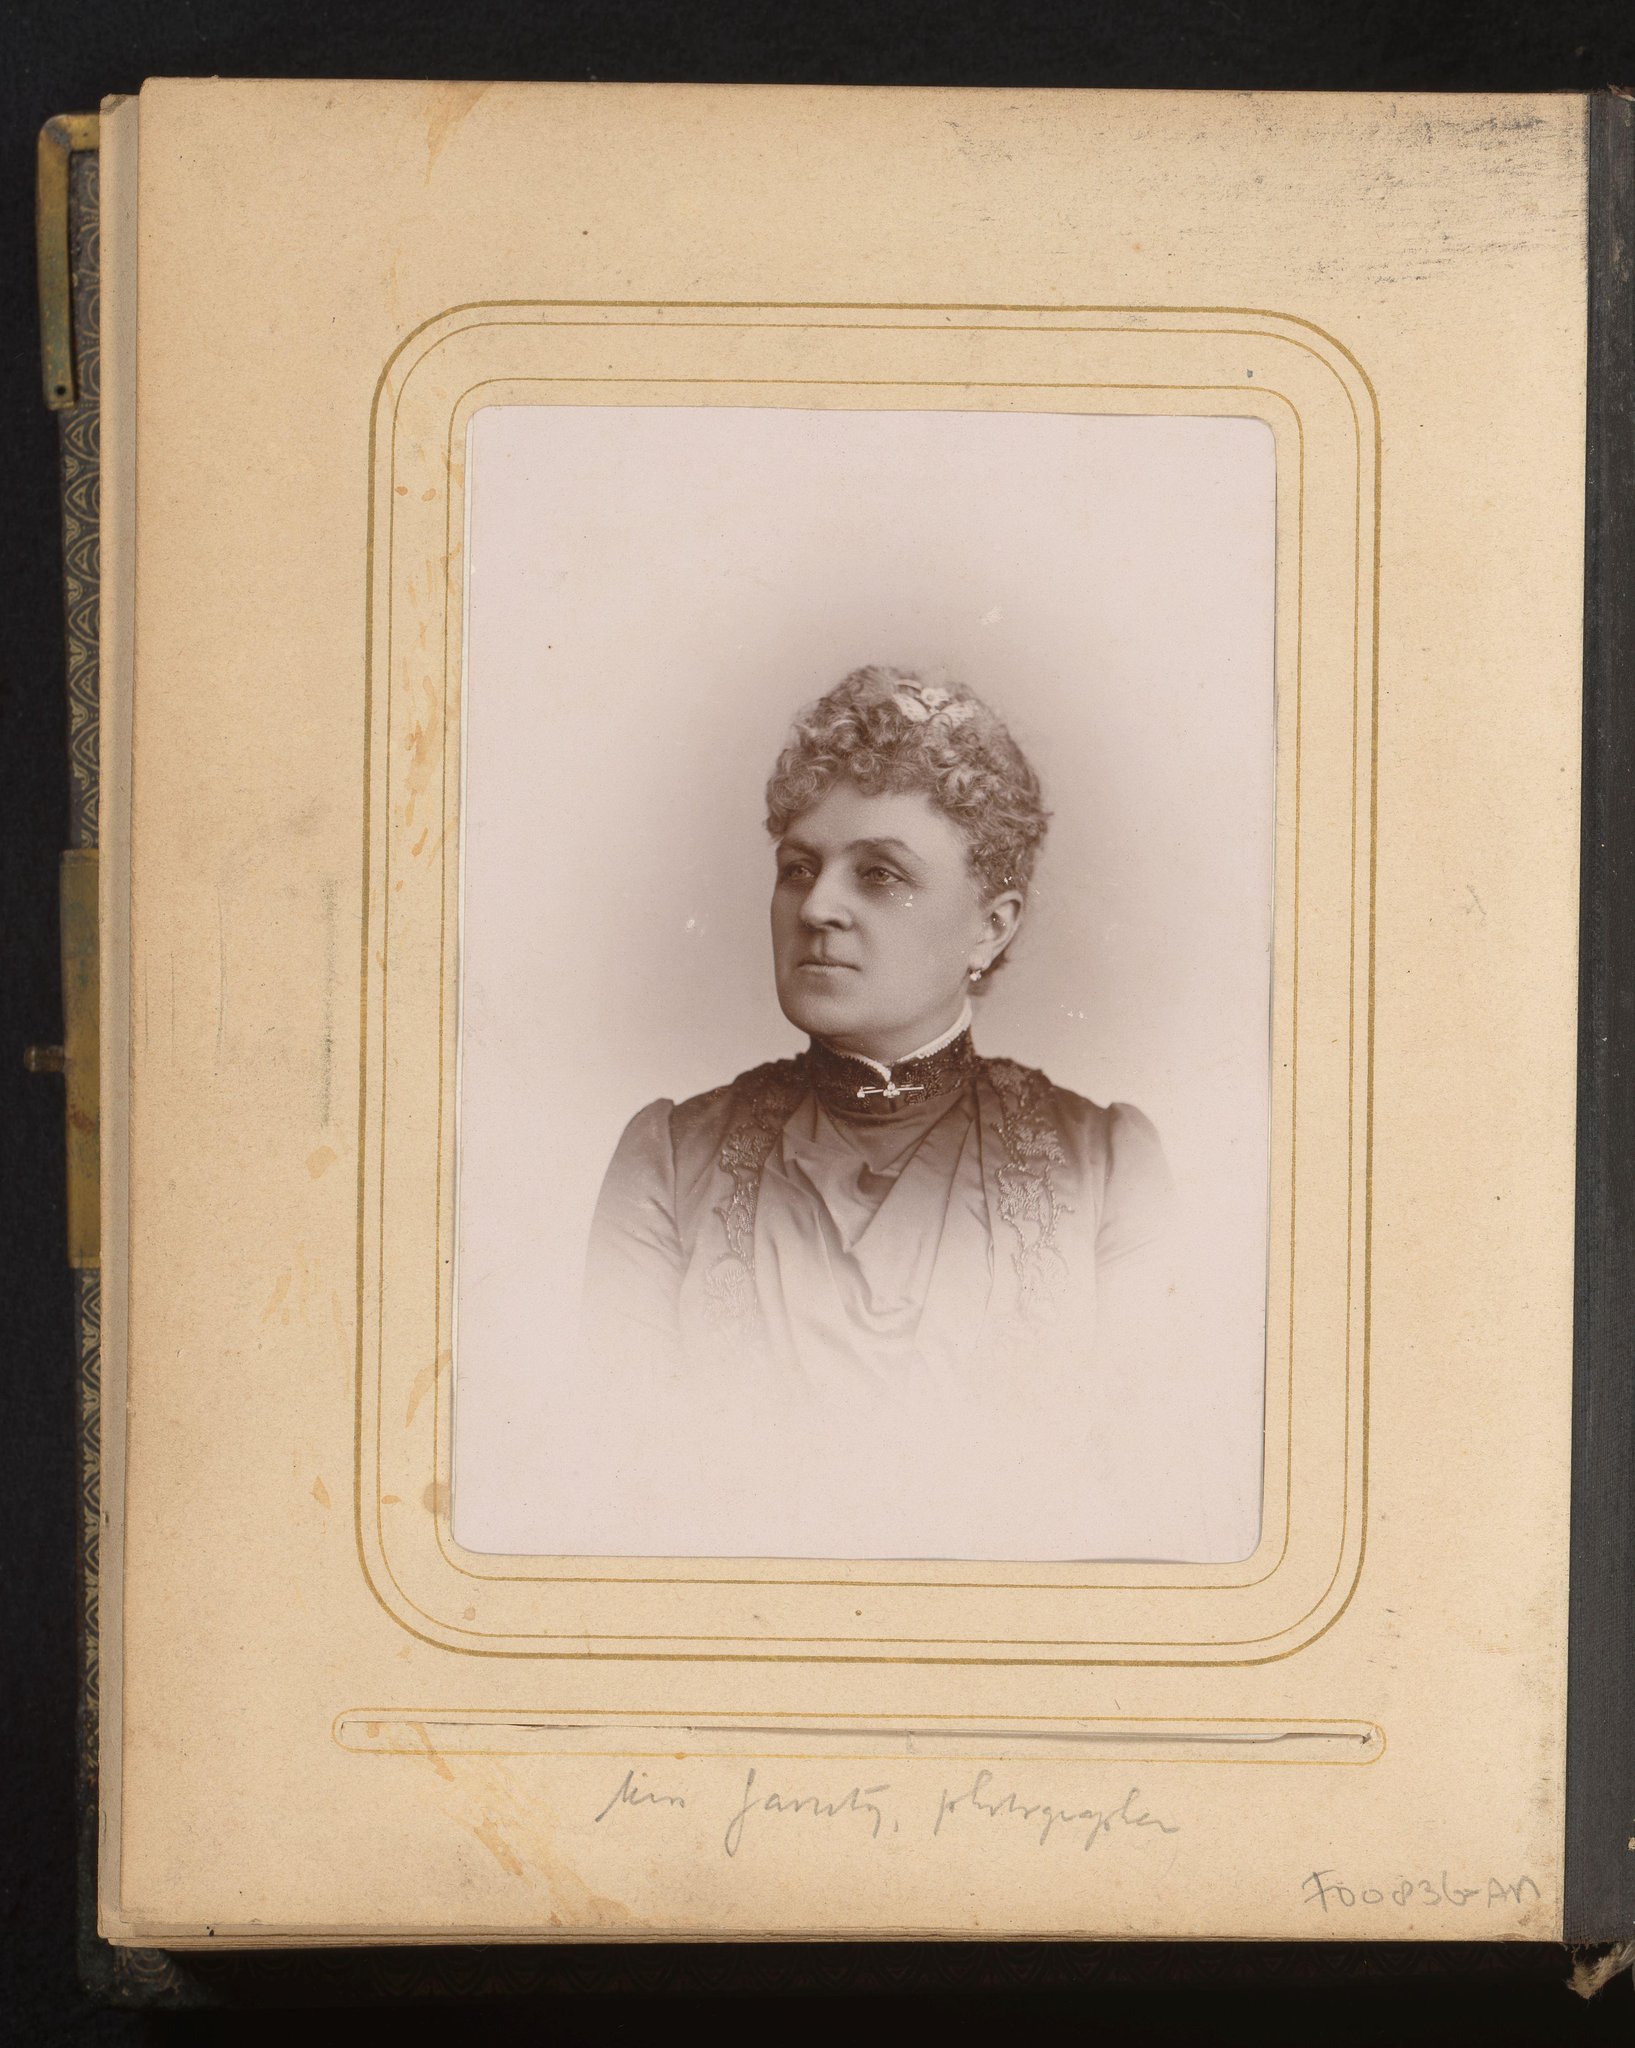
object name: photograph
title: Miss Garrity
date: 1880-1910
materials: cardboard, photographic support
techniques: collodion silver print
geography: chicago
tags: adult woman, historical persons